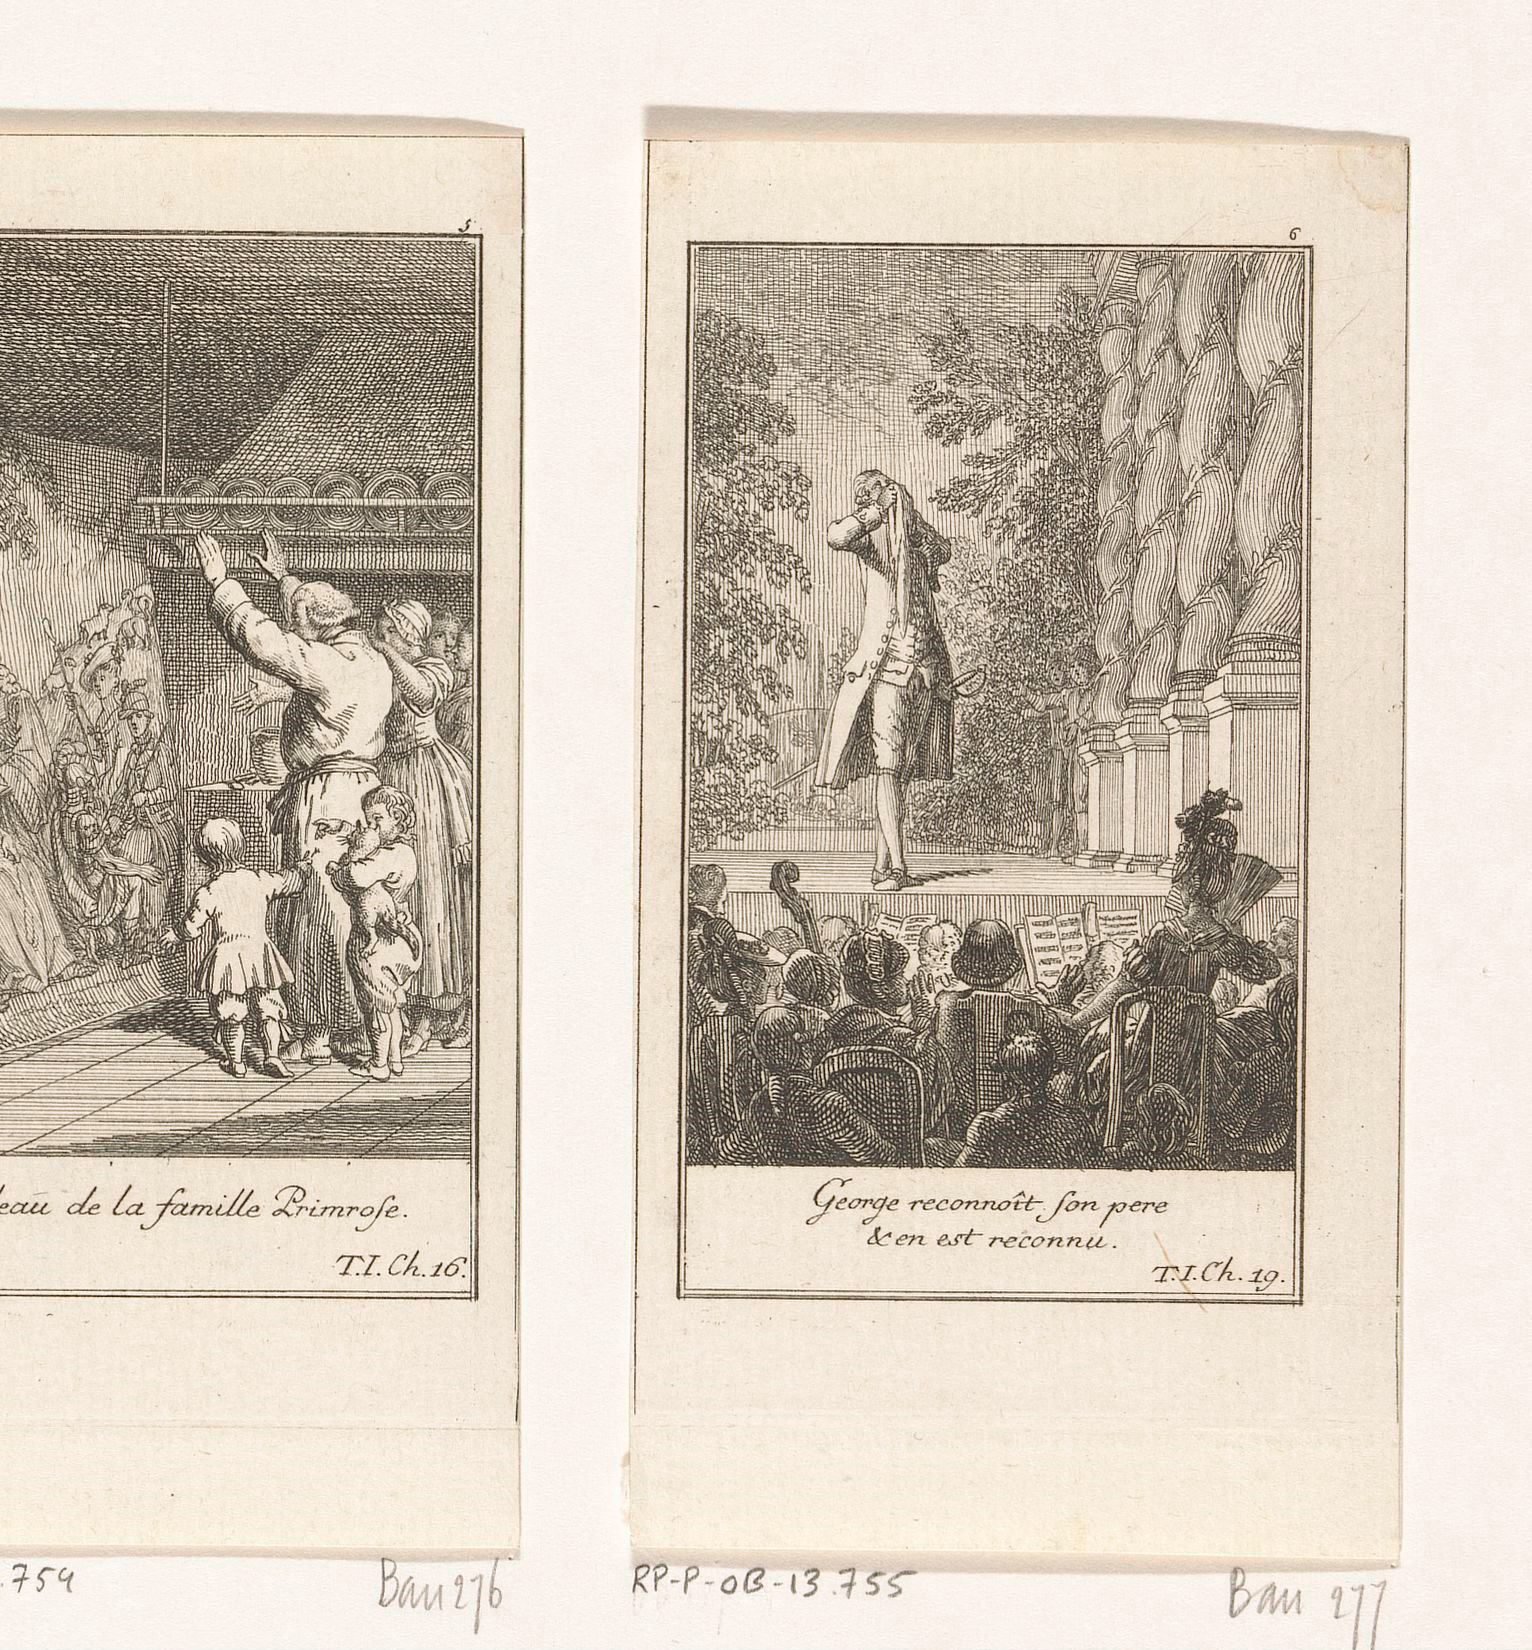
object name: print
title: George reconnoît son pere & en est reconnu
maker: daniel nikolaus chodowiecki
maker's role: draughtsman, print maker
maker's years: 1726-1801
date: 1776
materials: paper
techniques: etching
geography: berlin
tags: london, oliver goldsmith, theatre, theatrical performance, (goldsmith, the vicar of wakefield) specific works of literature (with author, title), weeping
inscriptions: collector's mark: Lugt 2228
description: Charles Primrose bezoekt bij toeval een voorstelling van een reizend theatergezelschap. De acteur op het toneel blijkt zijn zoon George. Charles heeft zijn familie al drie jaar niet gezien en barst in huilen uit als hij zijn vader en zijn voormalige verloofde Arabella herkent op de eerste rij. Rechtsboven genummerd: 6.